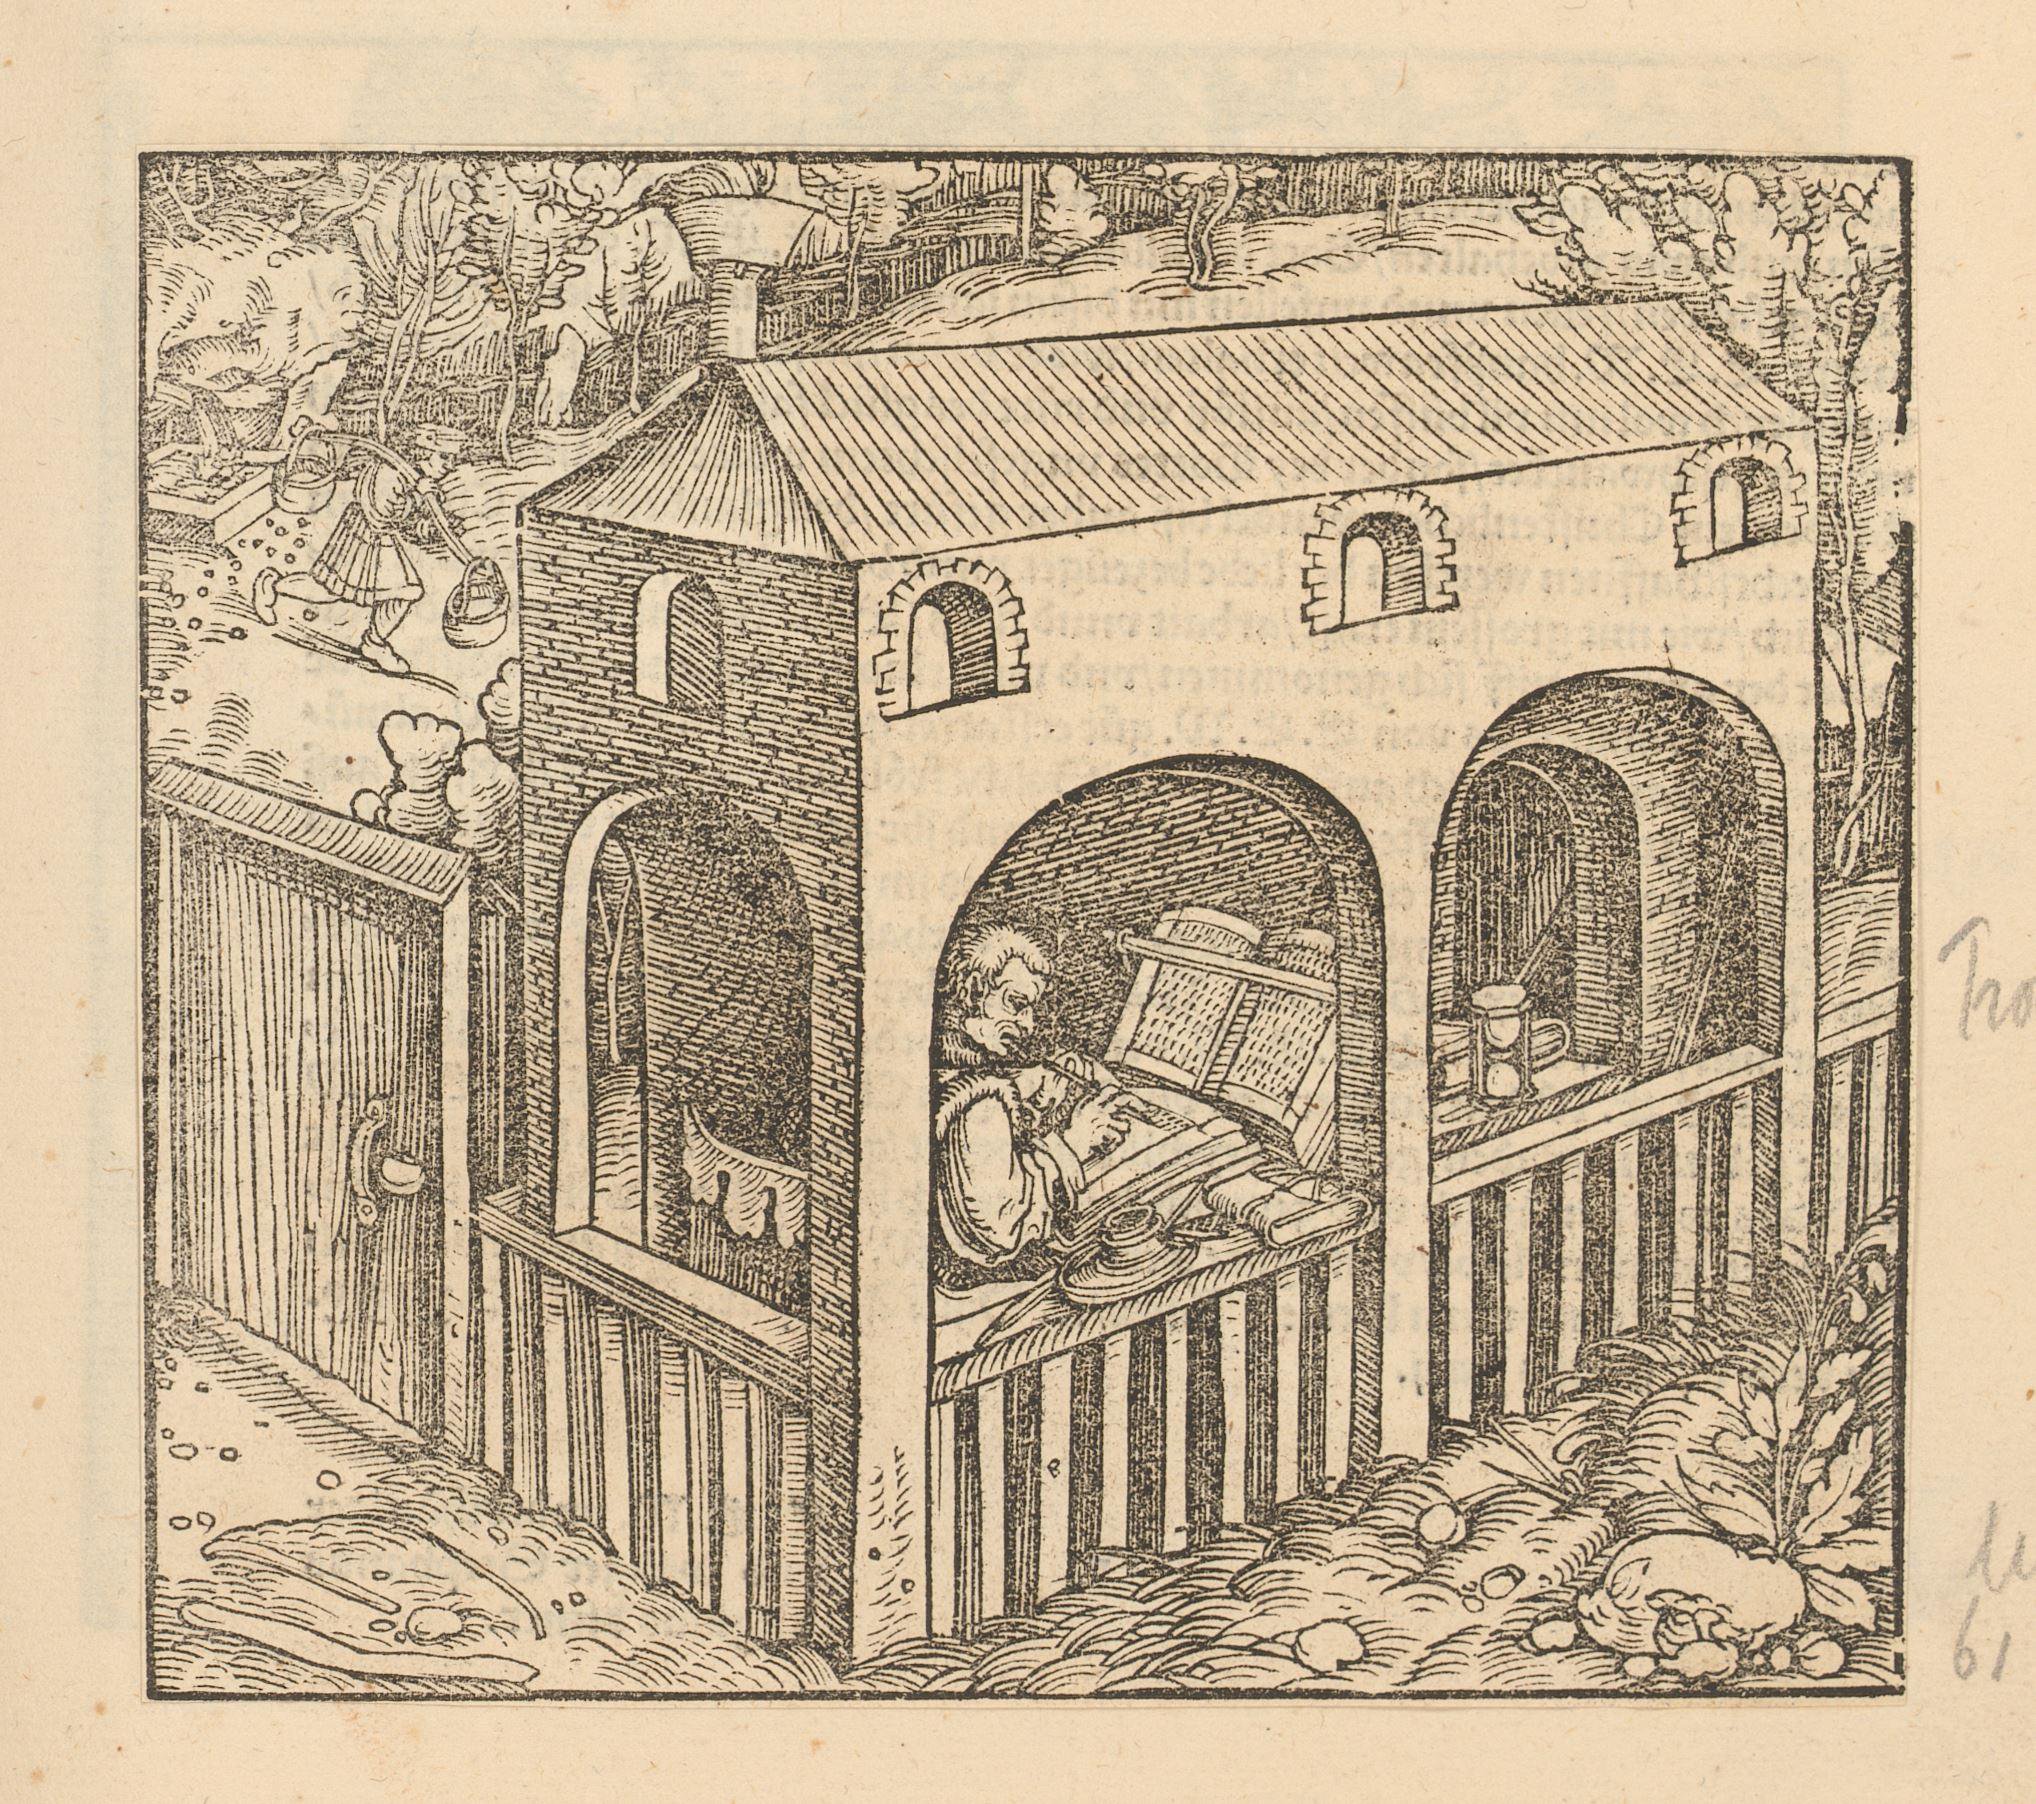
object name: album leaf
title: Francesco Petrarca schrijft in zijn huis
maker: Anonymous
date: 1514-1532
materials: paper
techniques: letterpress printing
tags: francesco petrarca, writer, poet, author (+ artist at work), writing accessories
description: Deze prent is gebruikt in: Petrarca, Francesco. Von der Artzney bayder Glück, des guten und widerwertigen: unnd weß sich ain yeder inn Gelück und Unglück halten sol (...). Augsburg: Heinrich Steiner, 1532. Deze uitgave is ook bekend onder de titel 'Trostspiegel in Glück und Unglück'.